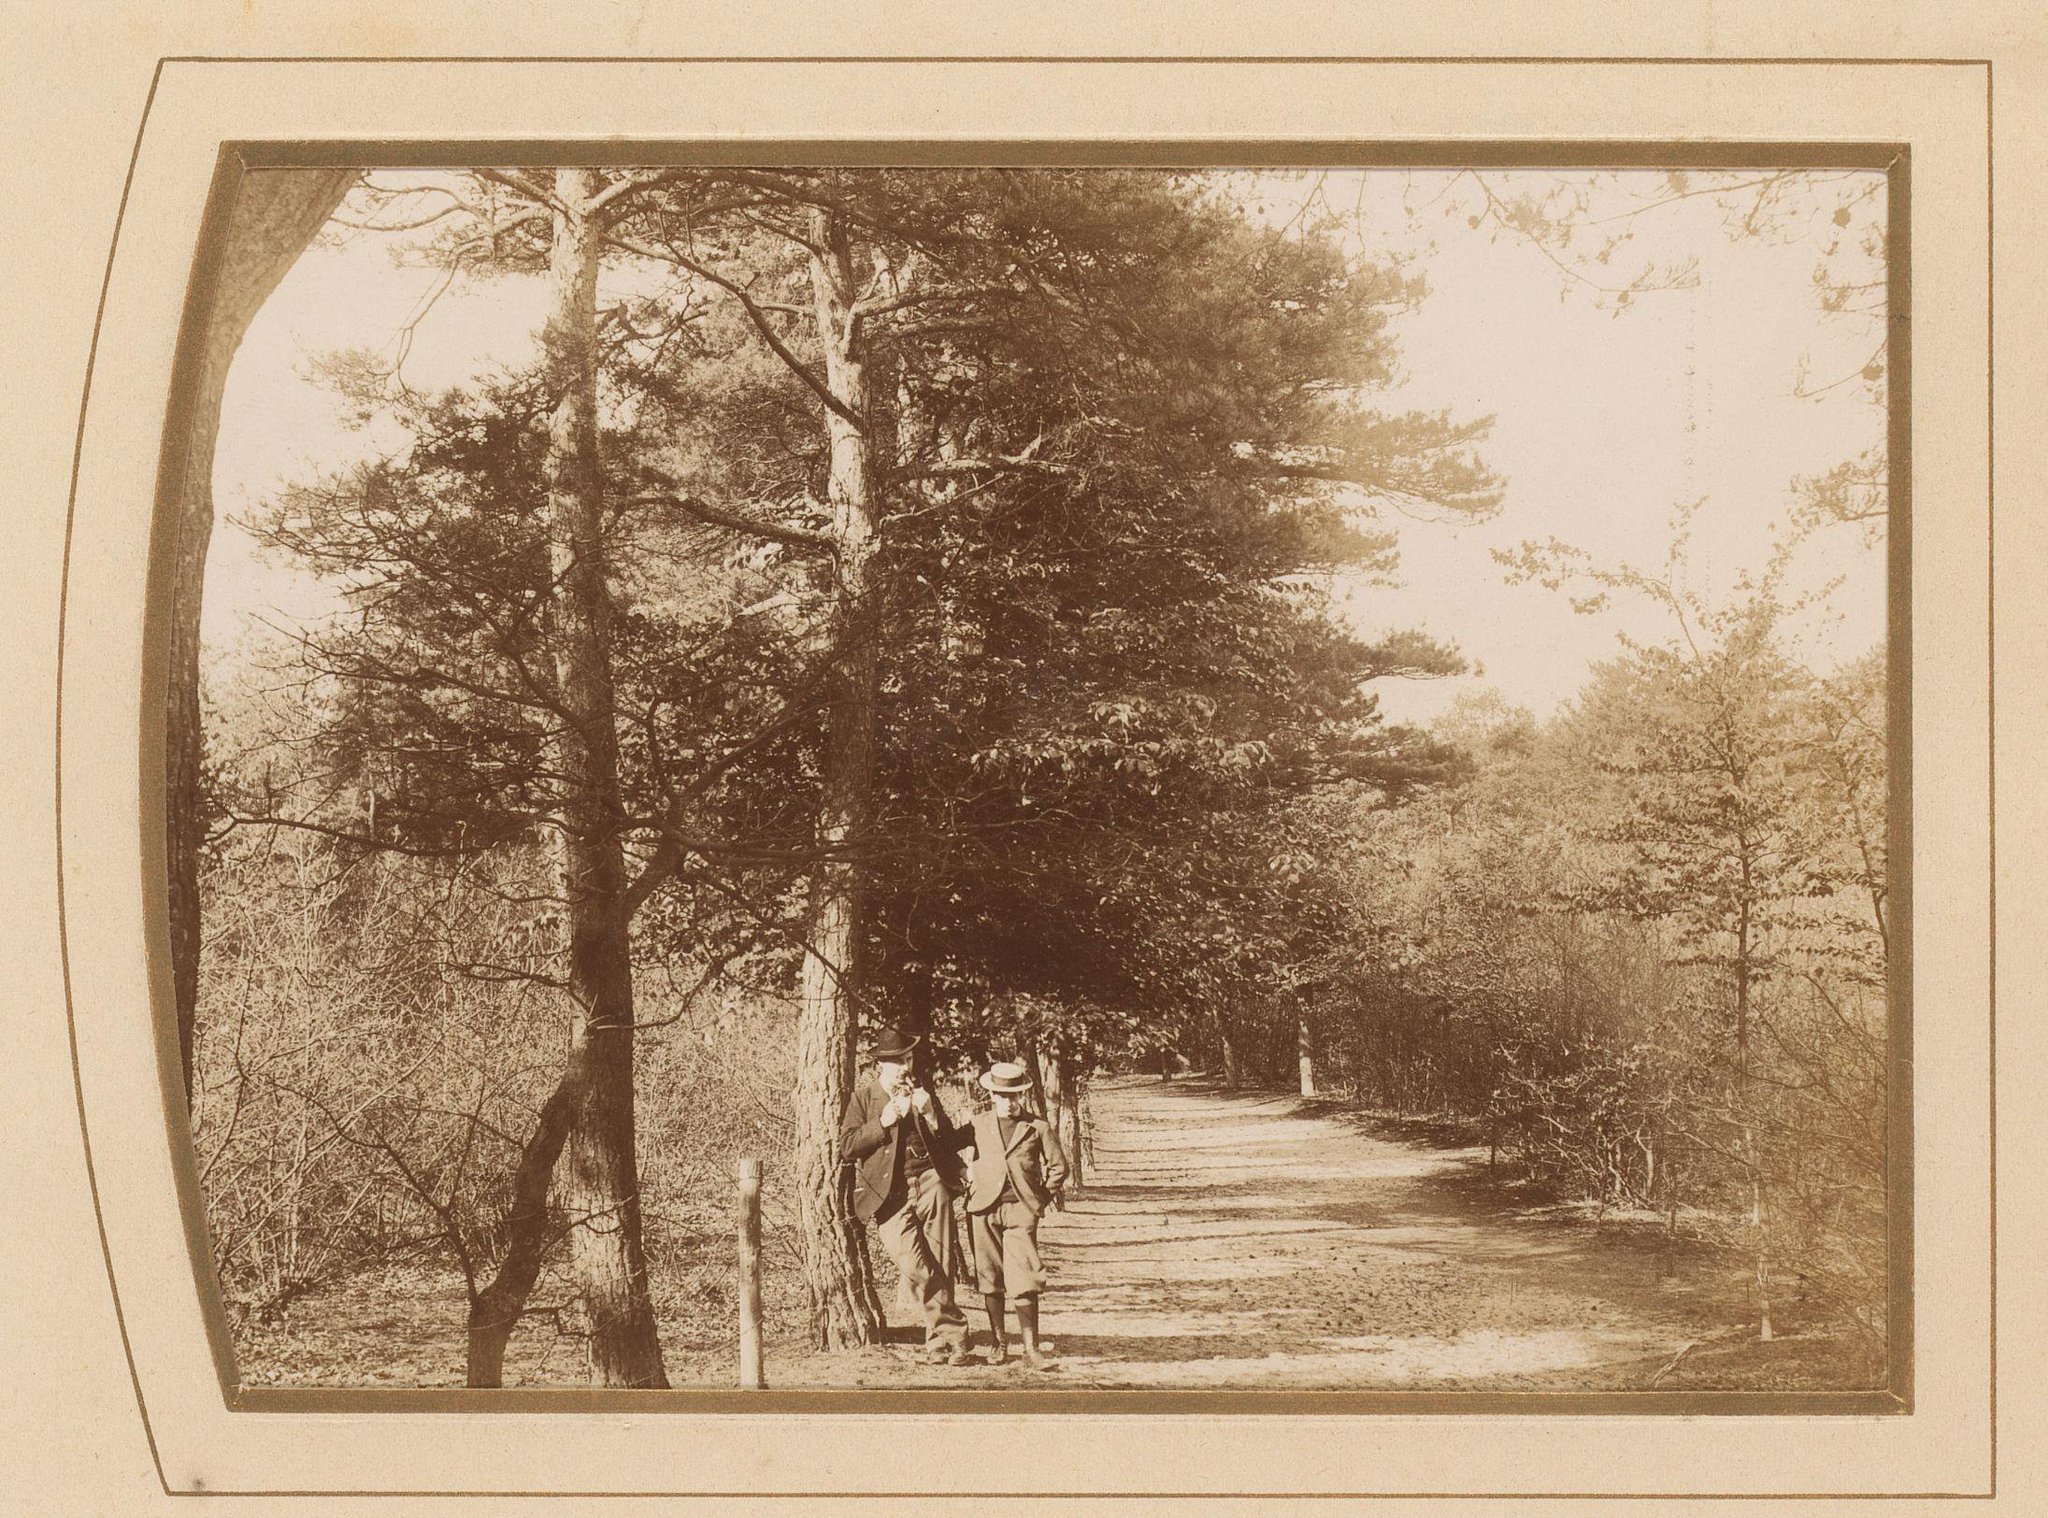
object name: photograph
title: Twee mannen op een bospad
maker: Anonymous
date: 1900-1920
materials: photographic support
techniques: collodion silver print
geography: netherlands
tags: adult man (+ two persons), forest path or lane